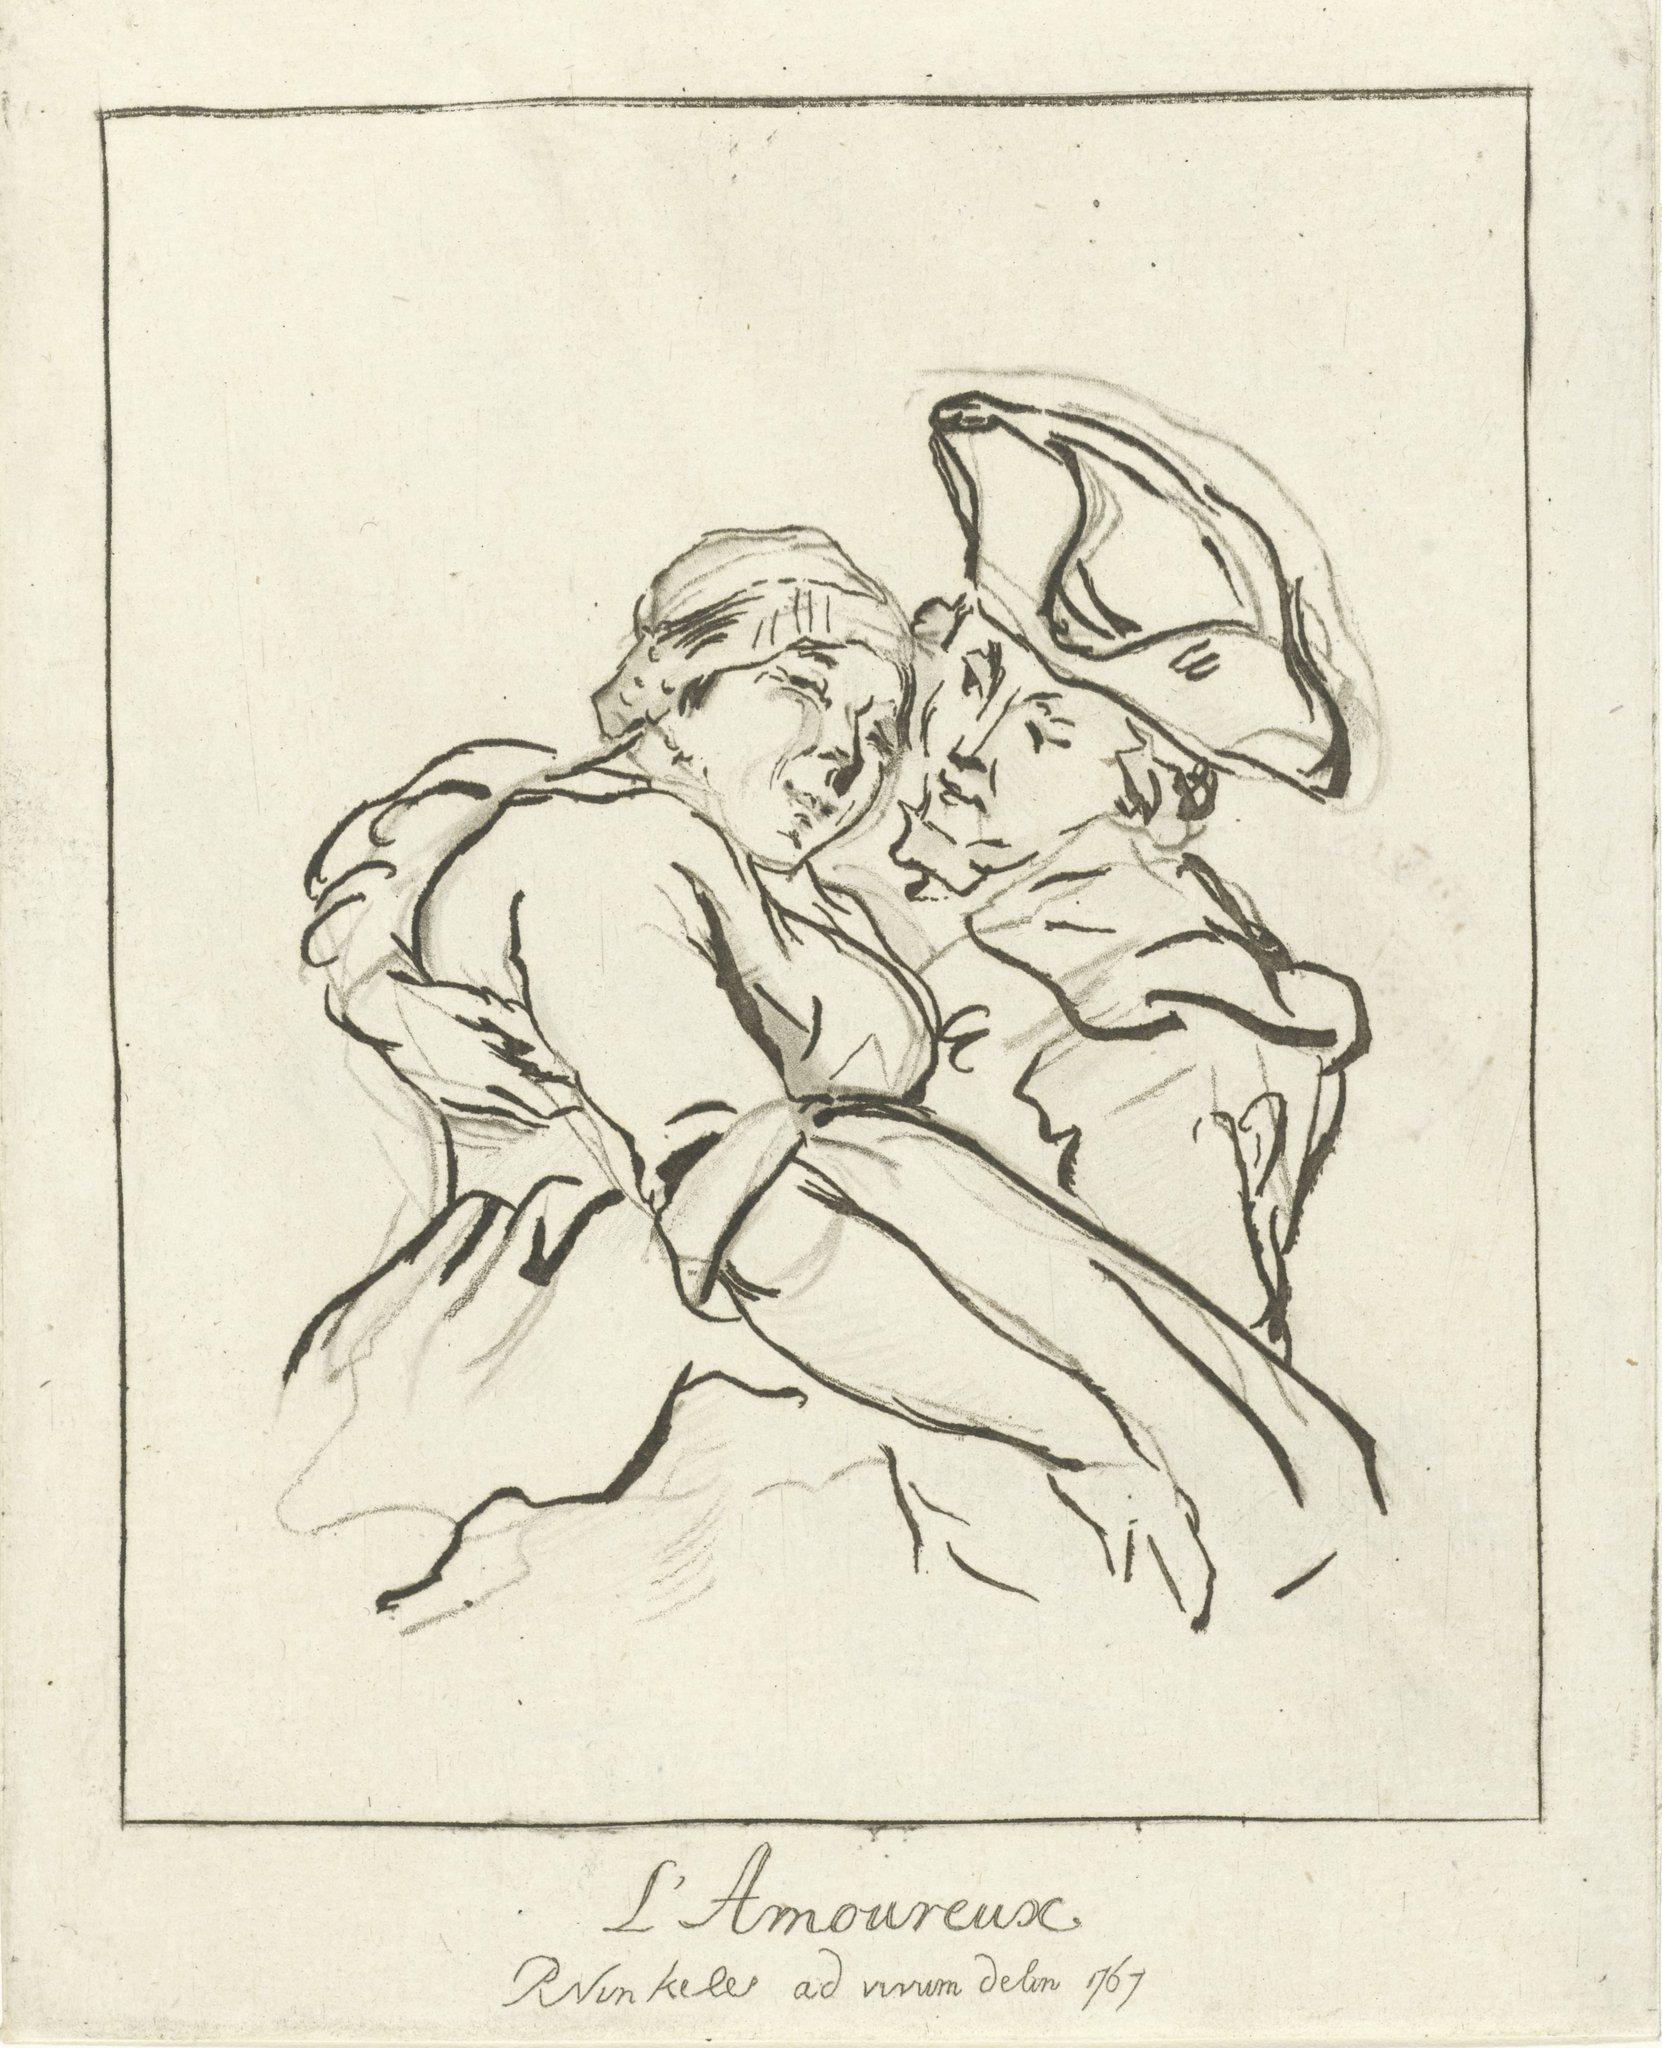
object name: print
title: Jurriaan Andriessen omhelst de meid uit 'de Zon'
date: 1767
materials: paper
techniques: etching, roulette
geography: amsterdam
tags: (lovers) embracing each other, 'symplegma'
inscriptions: collector's mark: Lugt 240, inscription: ‘geoffreerd mijne neef de Hoog Ed Geb Heer JL v Dussen // Ploos v Amstel F’